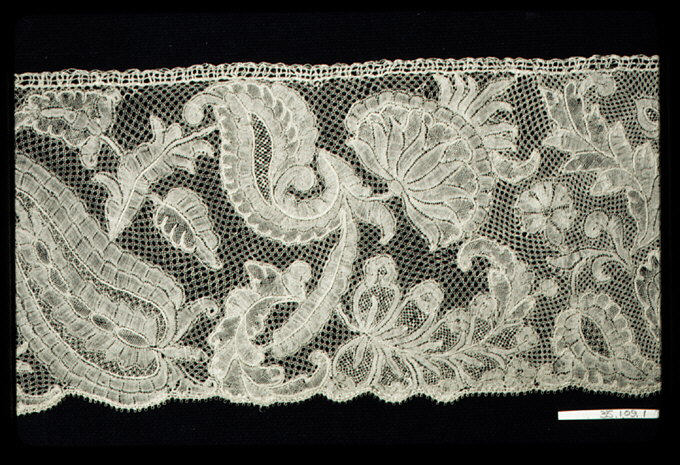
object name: border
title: Border (one of three)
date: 1701-1800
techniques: lace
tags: flowers